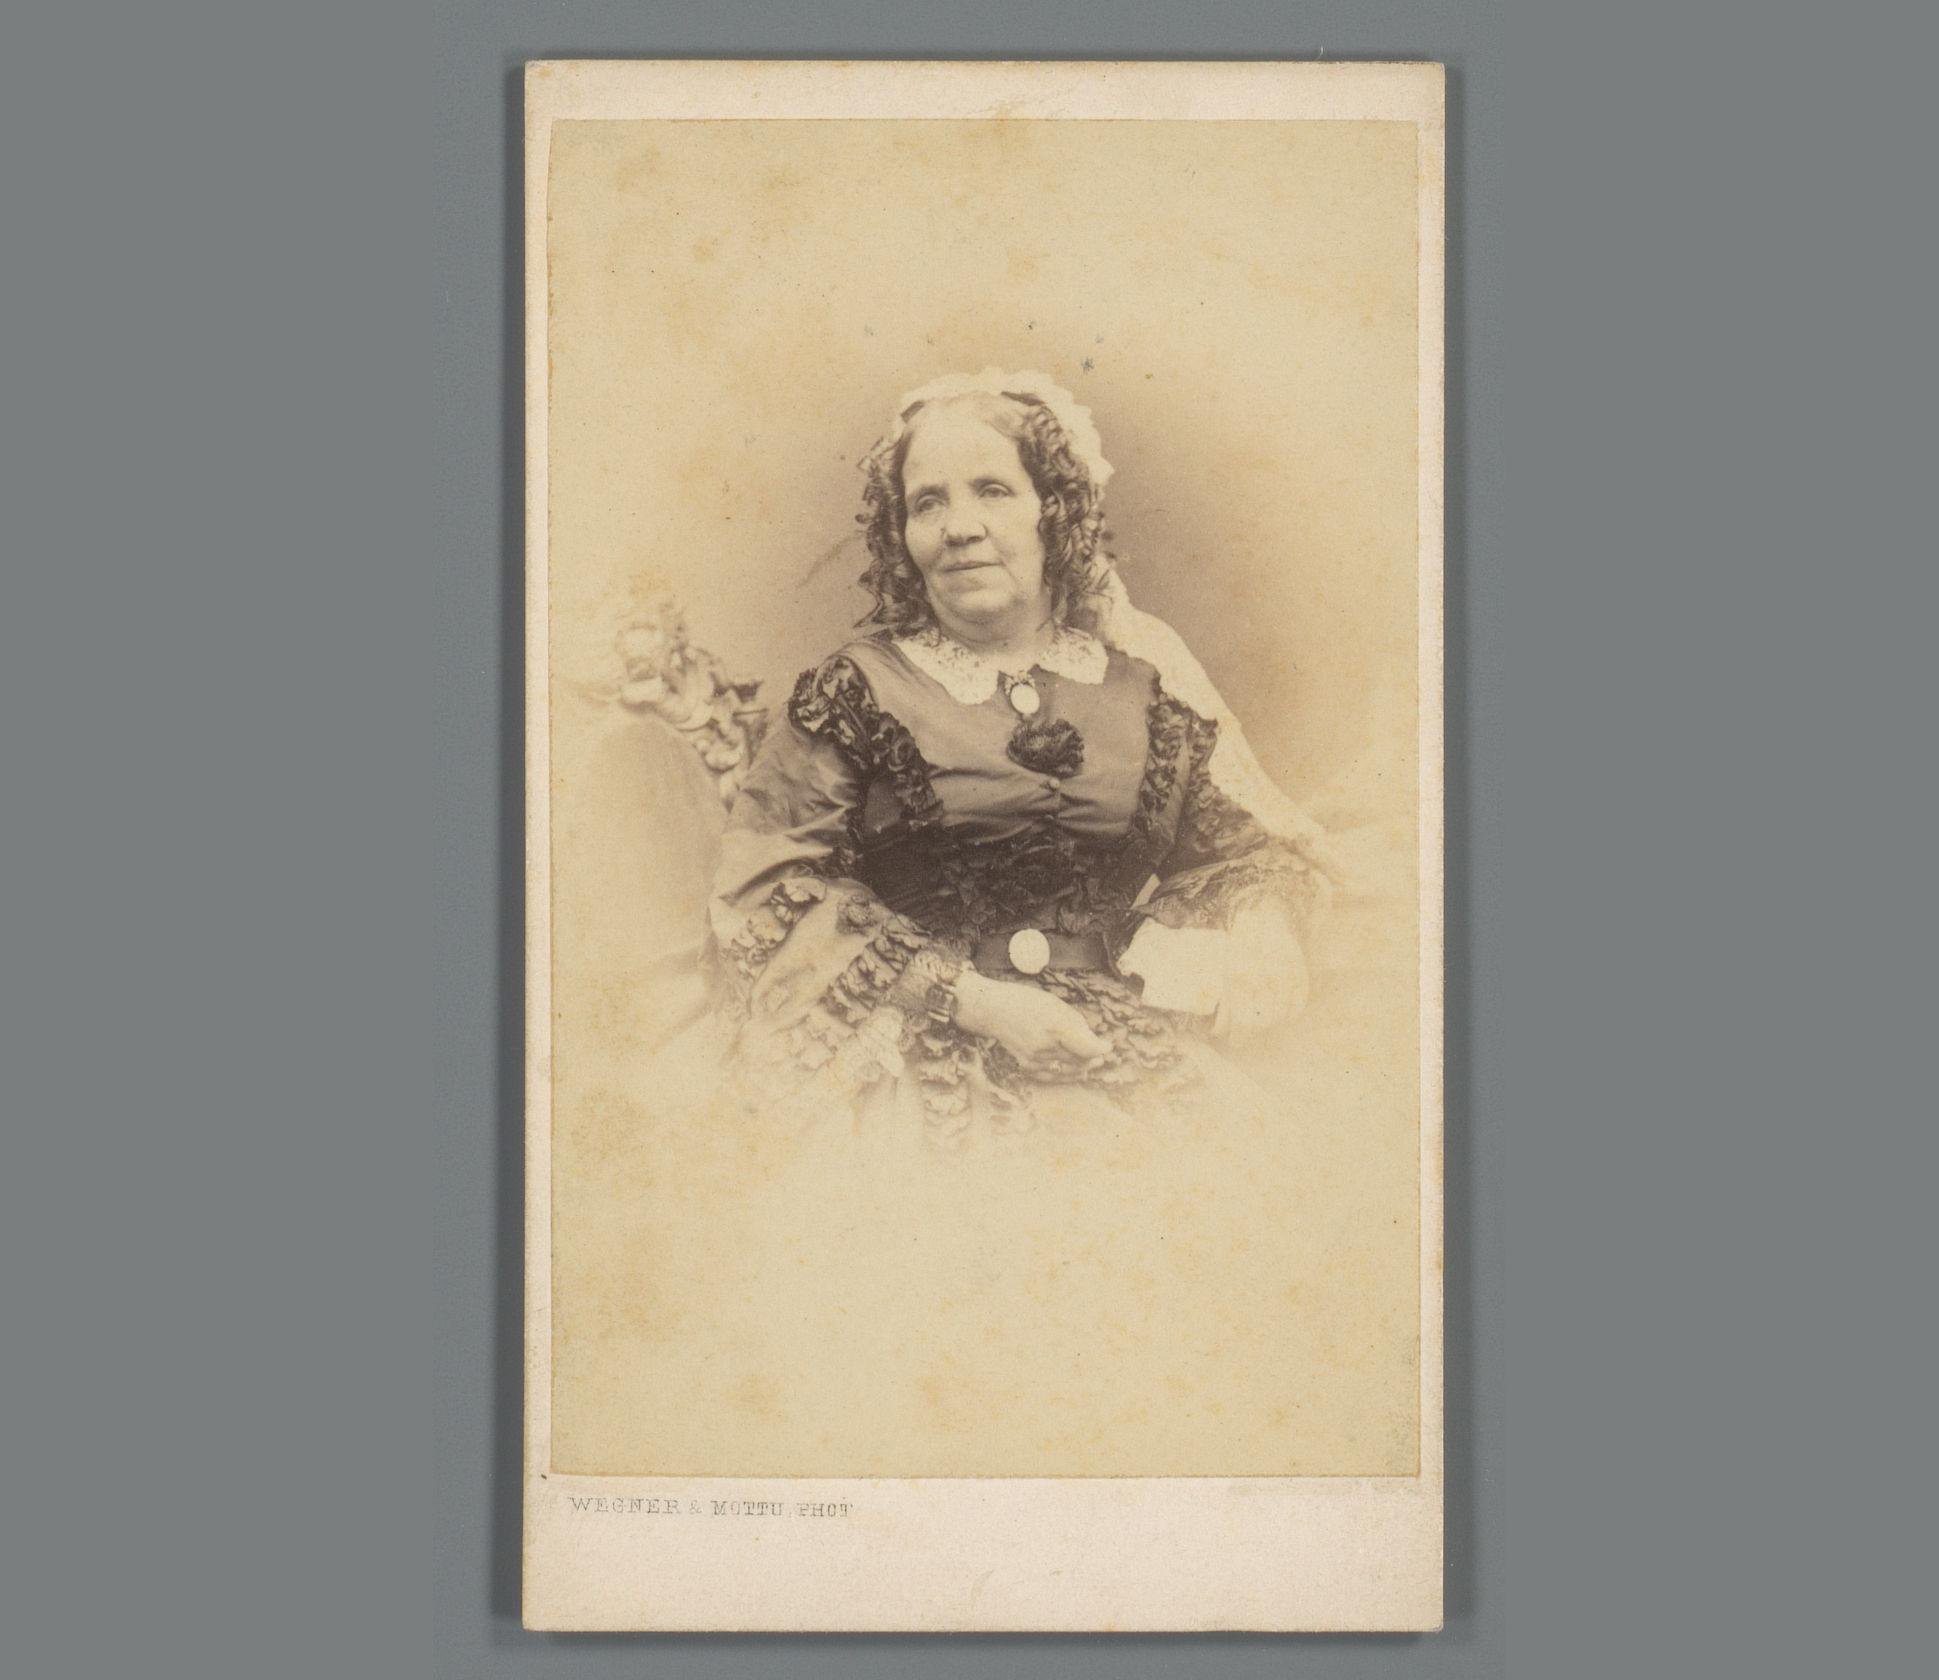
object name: carte de visite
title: Portret van Euphrosine Asser-Oppenheim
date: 1857-1864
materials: cardboard, paper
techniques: albumen print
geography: amsterdam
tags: cologne, historical persons - bb - woman, amsterdam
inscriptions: address: ‘Prinsengracht BB. 439/ AMSTERDAM’, inscription: ‘Rosine Asser-/ Oppenheim’